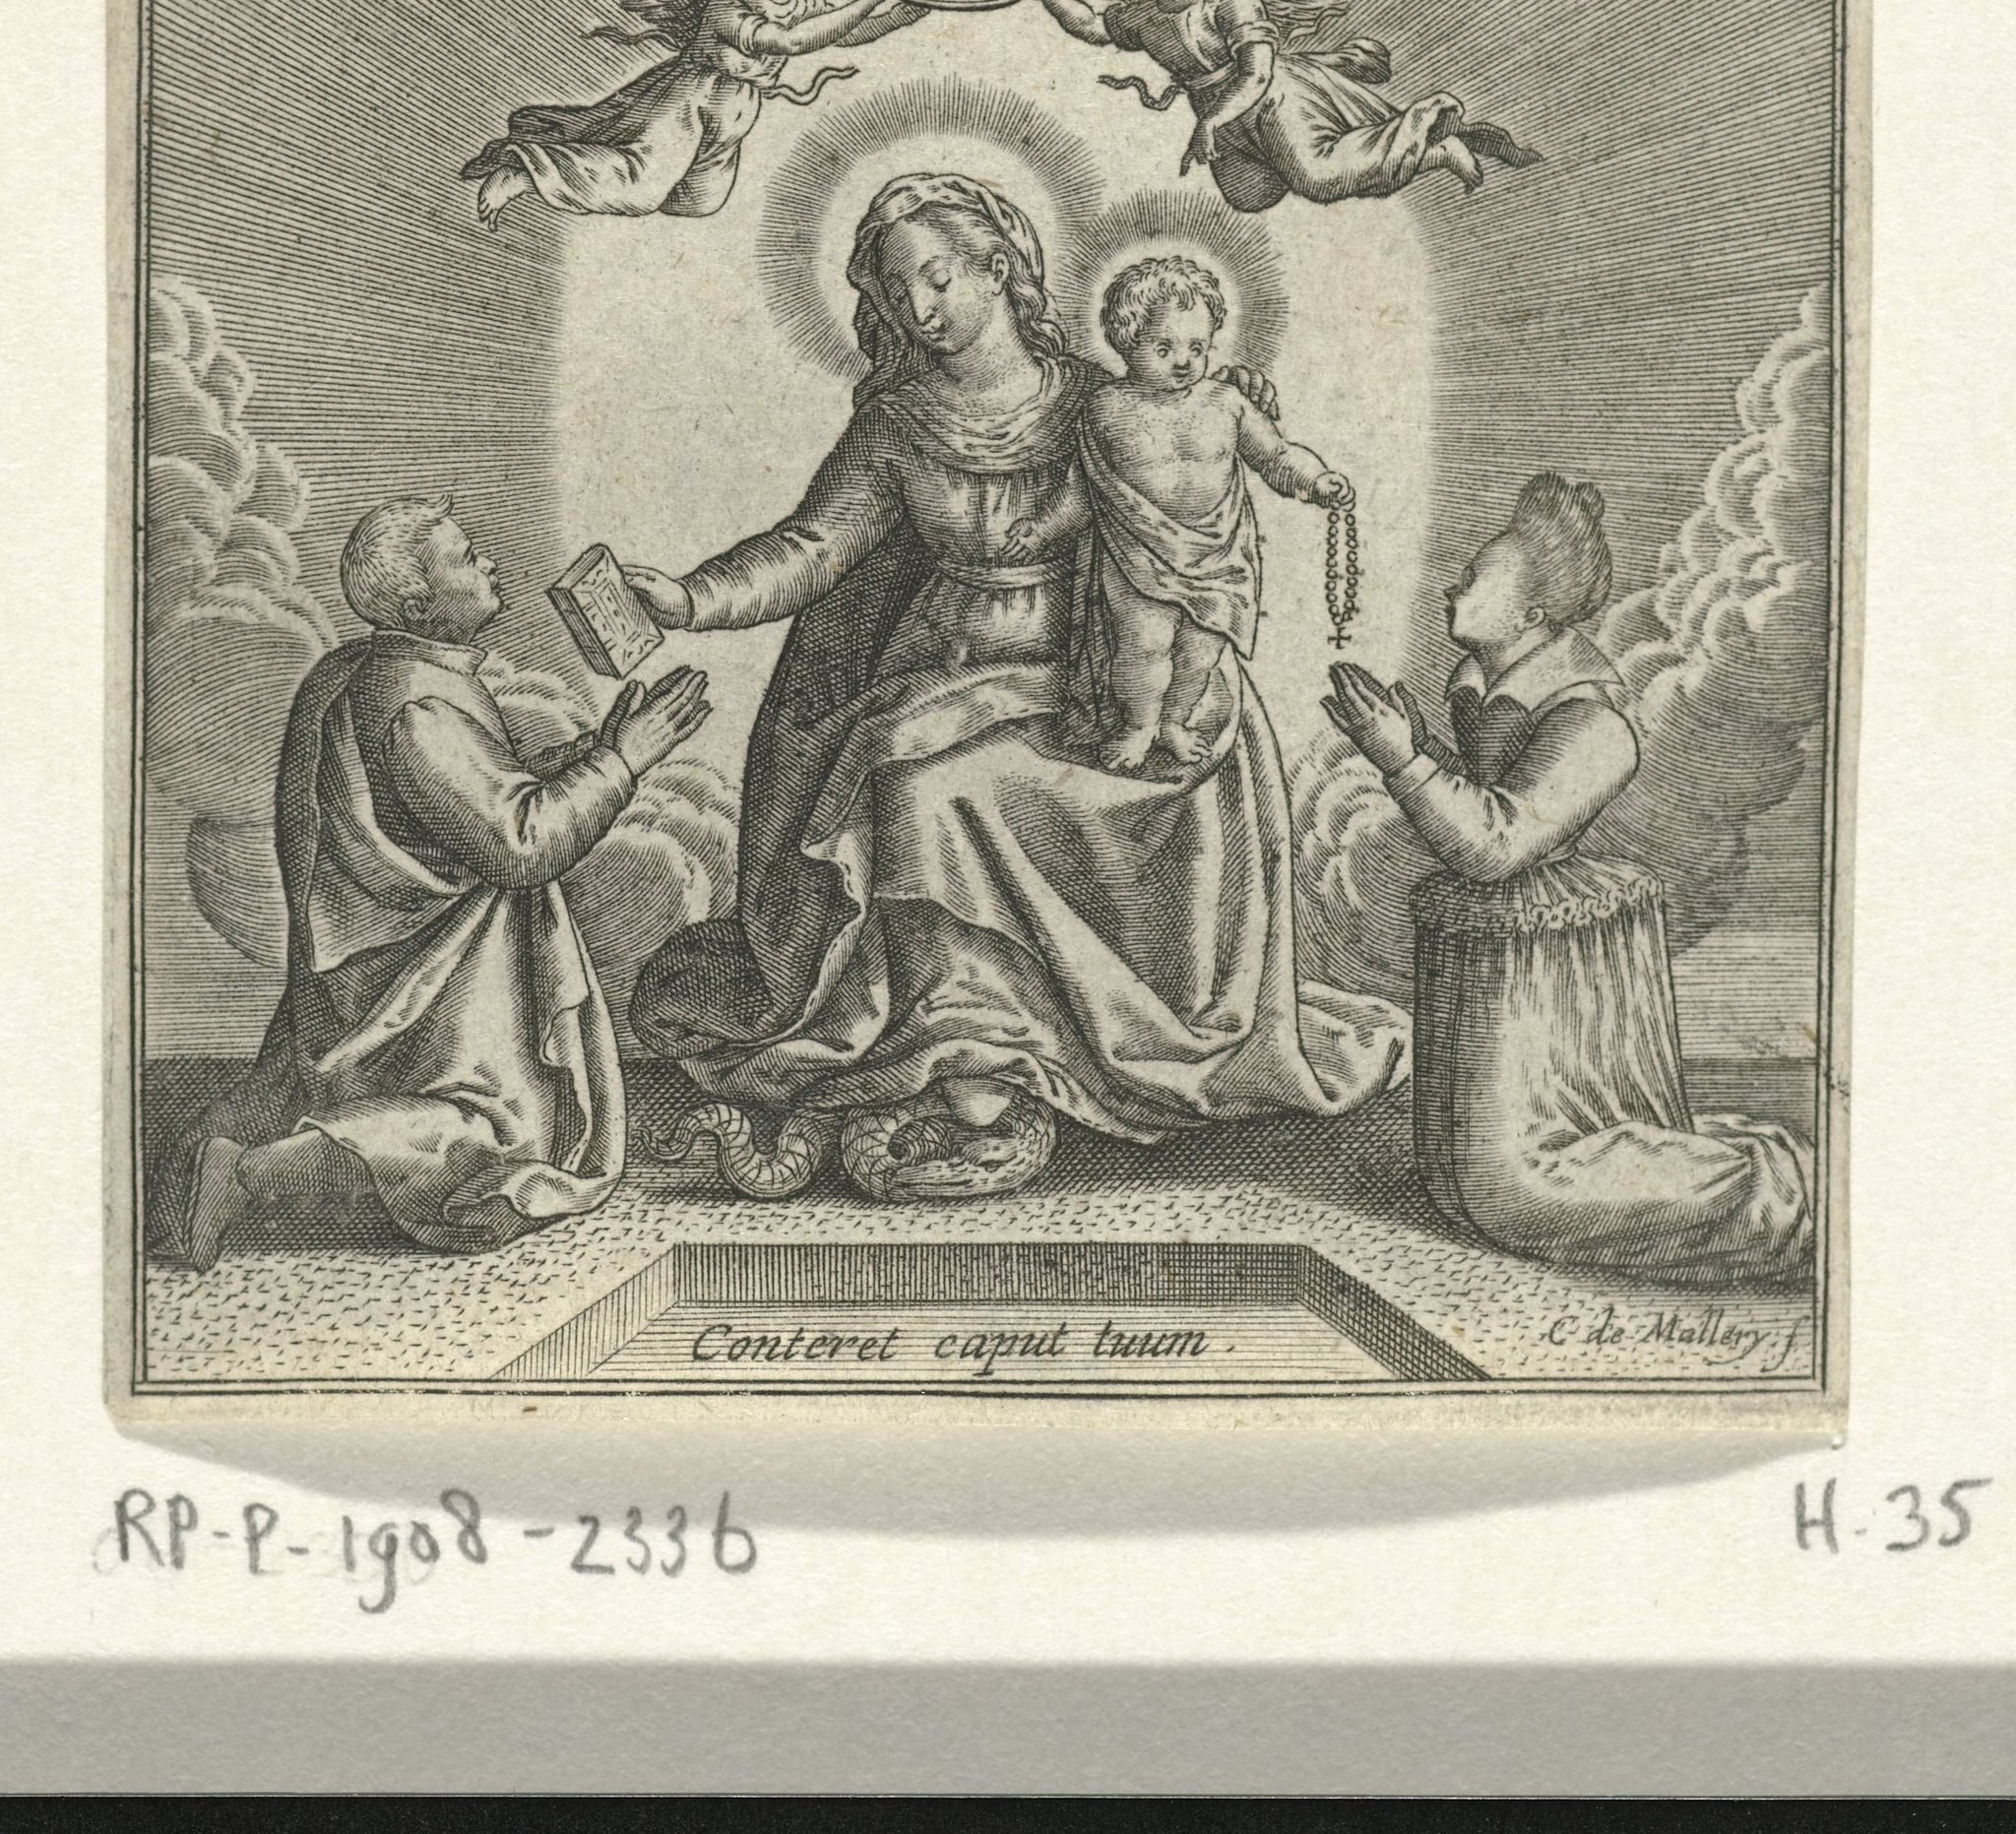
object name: print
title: Maria met Kind en twee schenkers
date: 1581-1645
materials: paper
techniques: engraving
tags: madonna: i.e. mary with the christ-child (+ donor(s), supplicant(s), whether or not with patron saint(s))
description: Maria en het Christuskind worden geflankeerd door twee geknielde schenkers; links een man aan wie zij een bijbel aanreikt en rechts een vrouw. Het Christuskind op Maria's schoot heeft een rozenkrans vast. Maria wordt gekroond door twee boven haar zwevende engelen en zij vertrapt met haar voet de slang. Onderaan een regel in het Latijn.